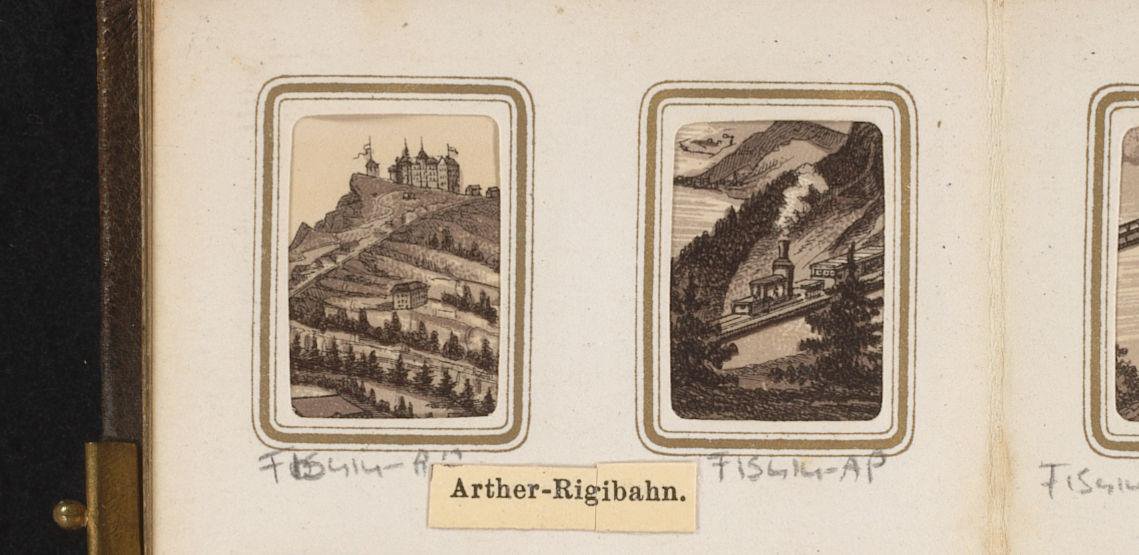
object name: print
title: Gezicht op de Arth-Rigi-Bahn in Schwyz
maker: Anonymous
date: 1851-1910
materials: paper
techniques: lithograph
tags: railway, train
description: Deze prent maakt deel uit van een album.